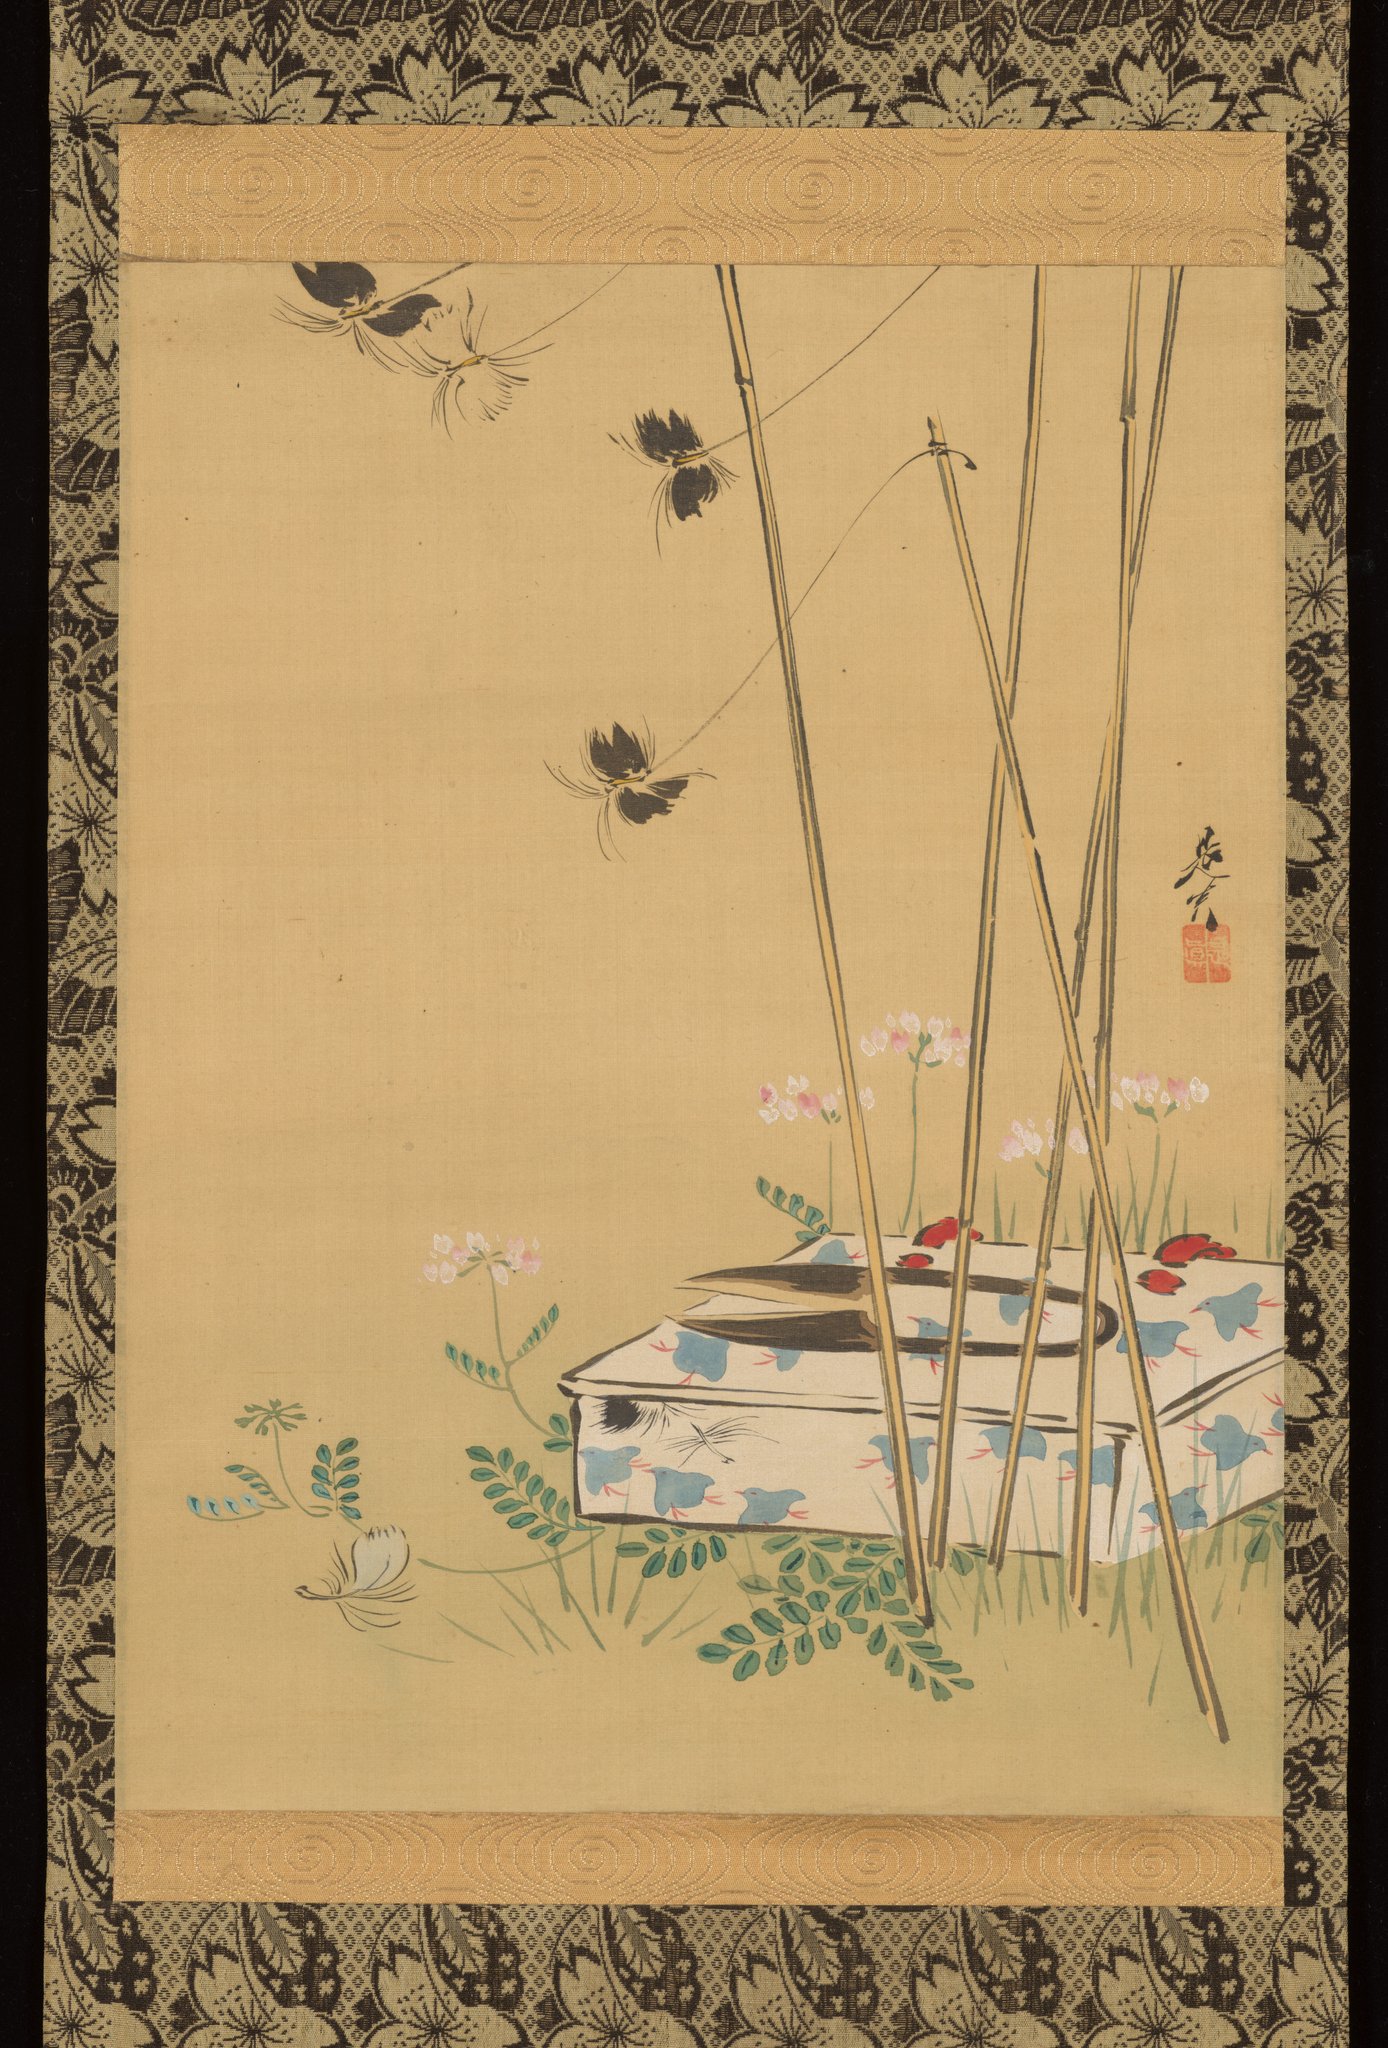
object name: hanging scroll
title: Garden Scene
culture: japanese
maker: shibata zeshin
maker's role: artist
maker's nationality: japanese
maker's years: 1807-1891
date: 1801-1900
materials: ink, silk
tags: butterflies,spring